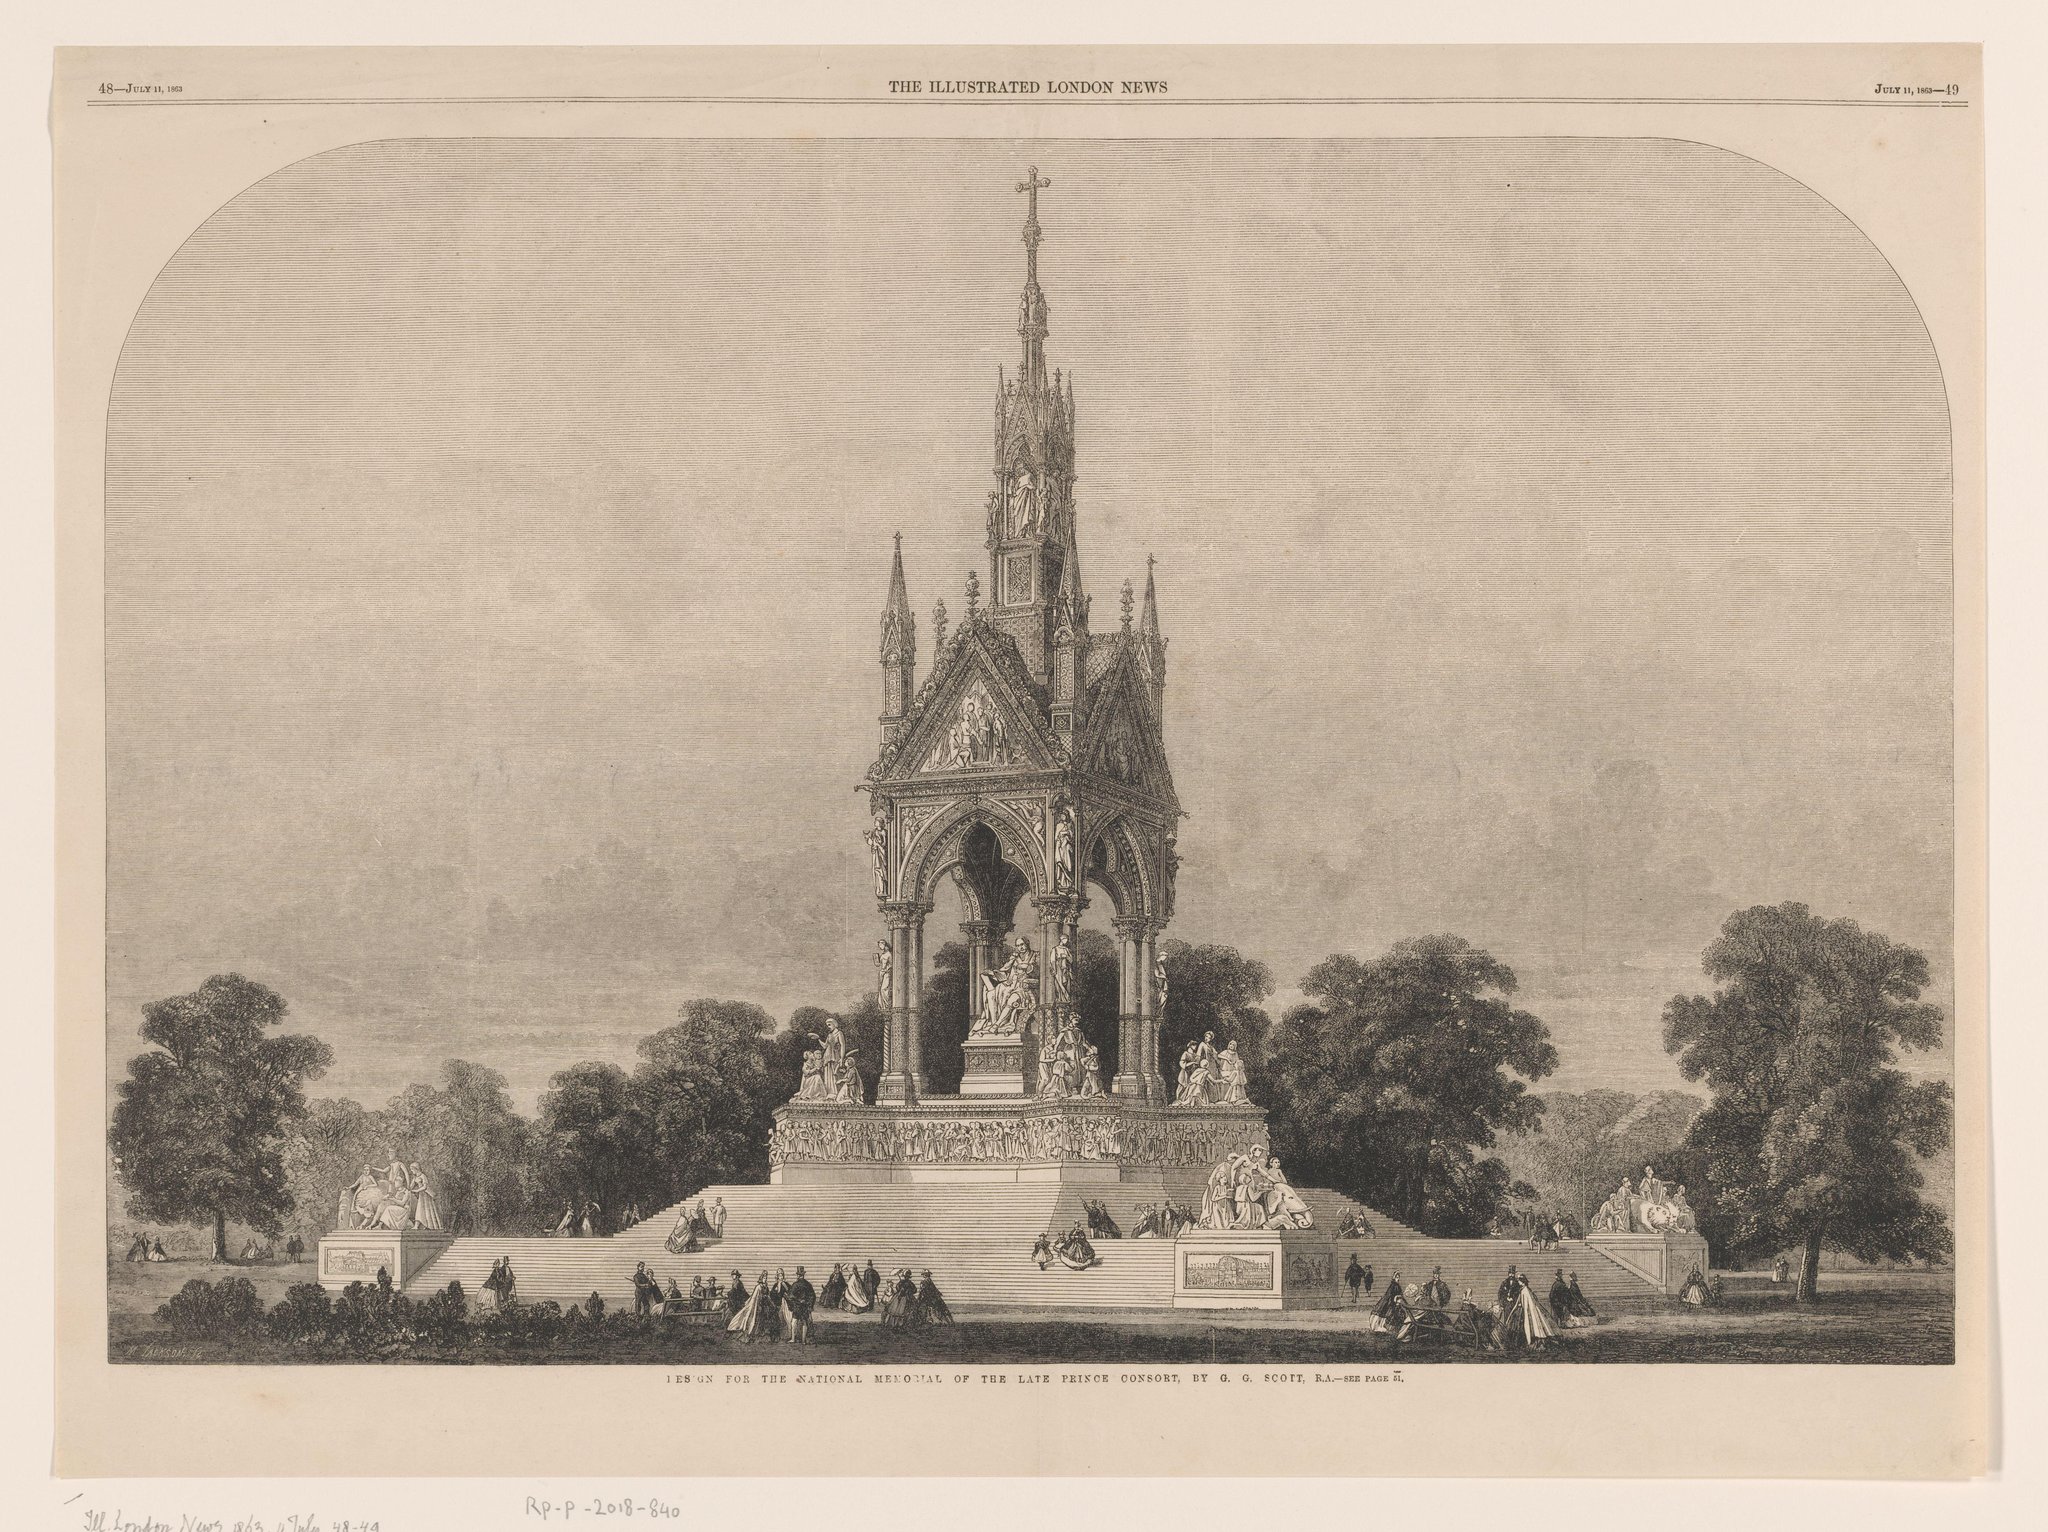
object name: print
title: Sunday morning in St. Paul's Cathedral: a view from the whispering gallery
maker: mason jackson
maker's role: print maker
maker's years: 1819-1903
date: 1863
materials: paper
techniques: engraving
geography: london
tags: monument, statue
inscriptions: collector's mark: Lugt 2228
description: Prent gebruikt in: The Illustrated London News, 11 juli 1863, p. 48-49.